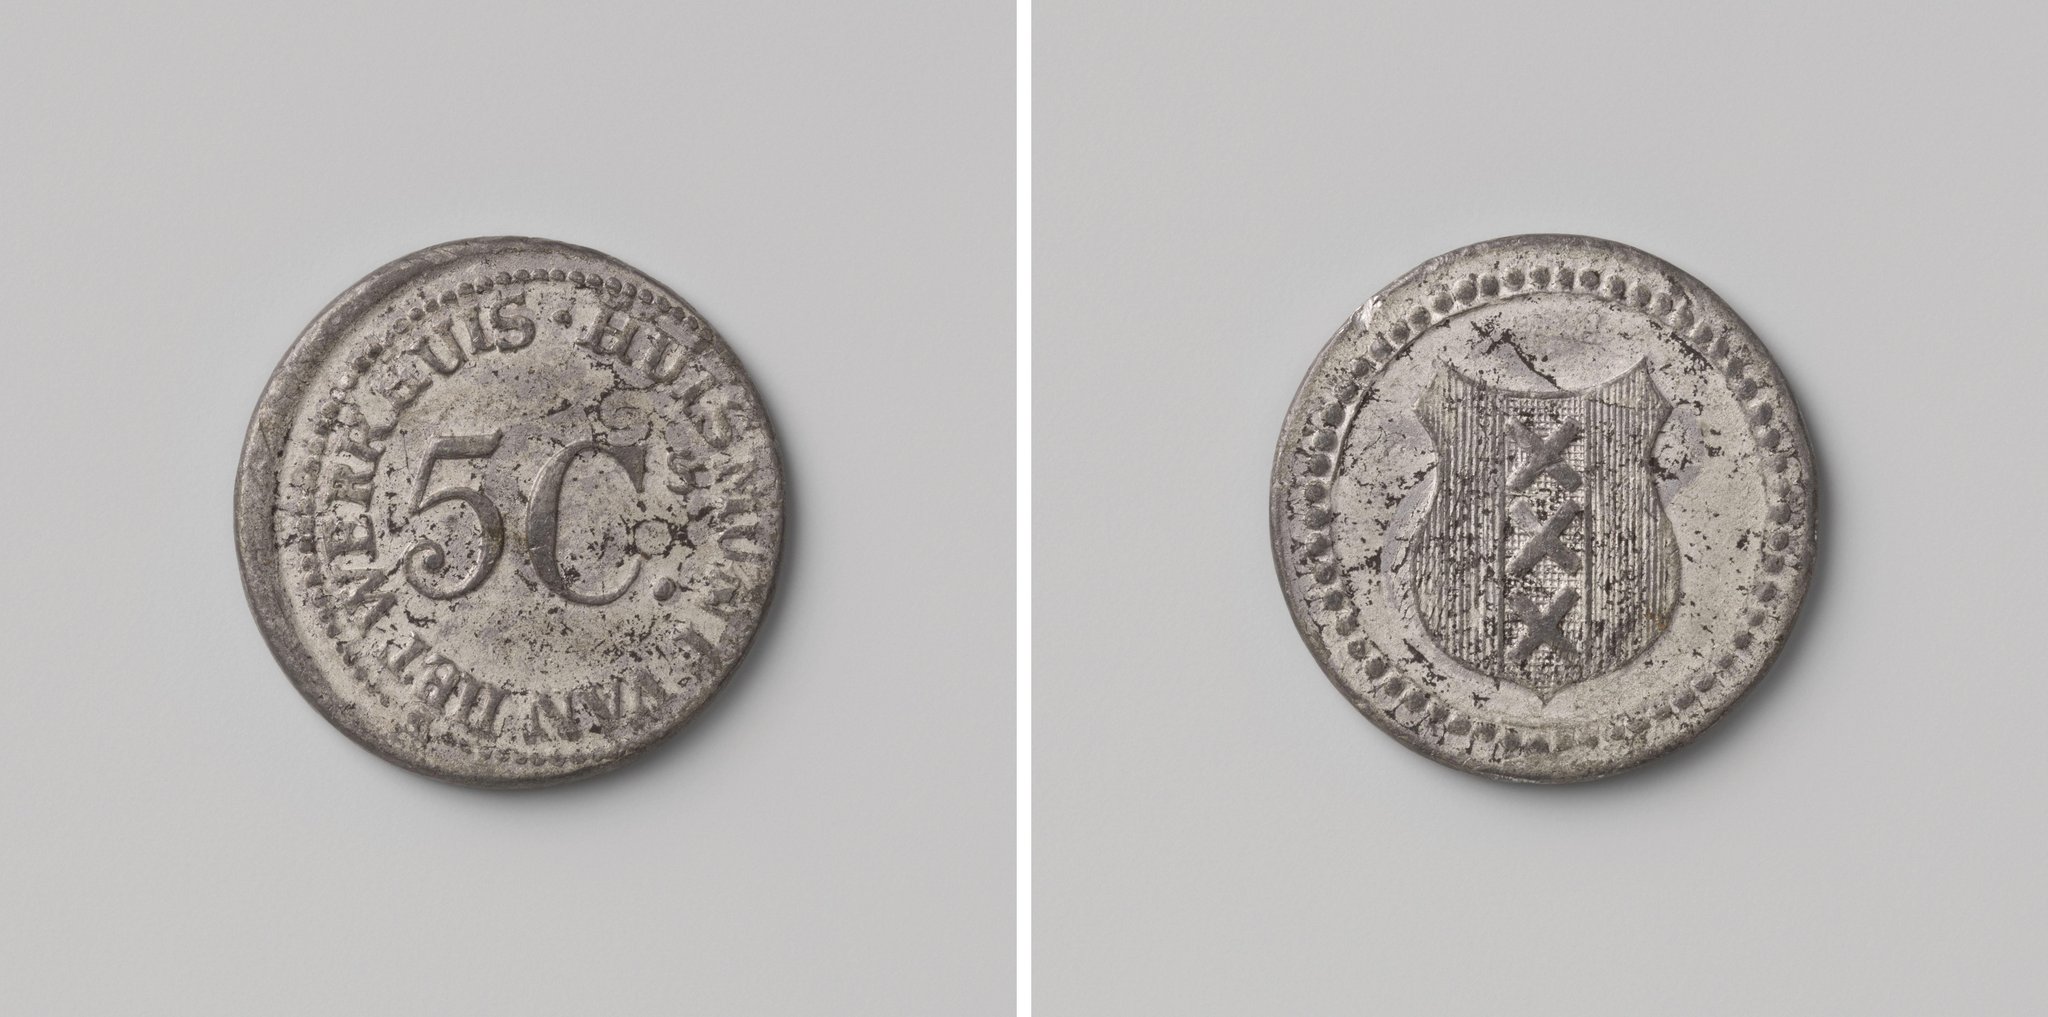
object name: vijf cent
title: Werkhuis te Amsterdam, huismunt ter waarde van vijf cent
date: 1824-1837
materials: lead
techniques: striking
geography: amsterdam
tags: amsterdam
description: Voorzijde: waardeaanduiding binnen omschrift en parelrand. Keerzijde: wapenschild binnen parelrand.